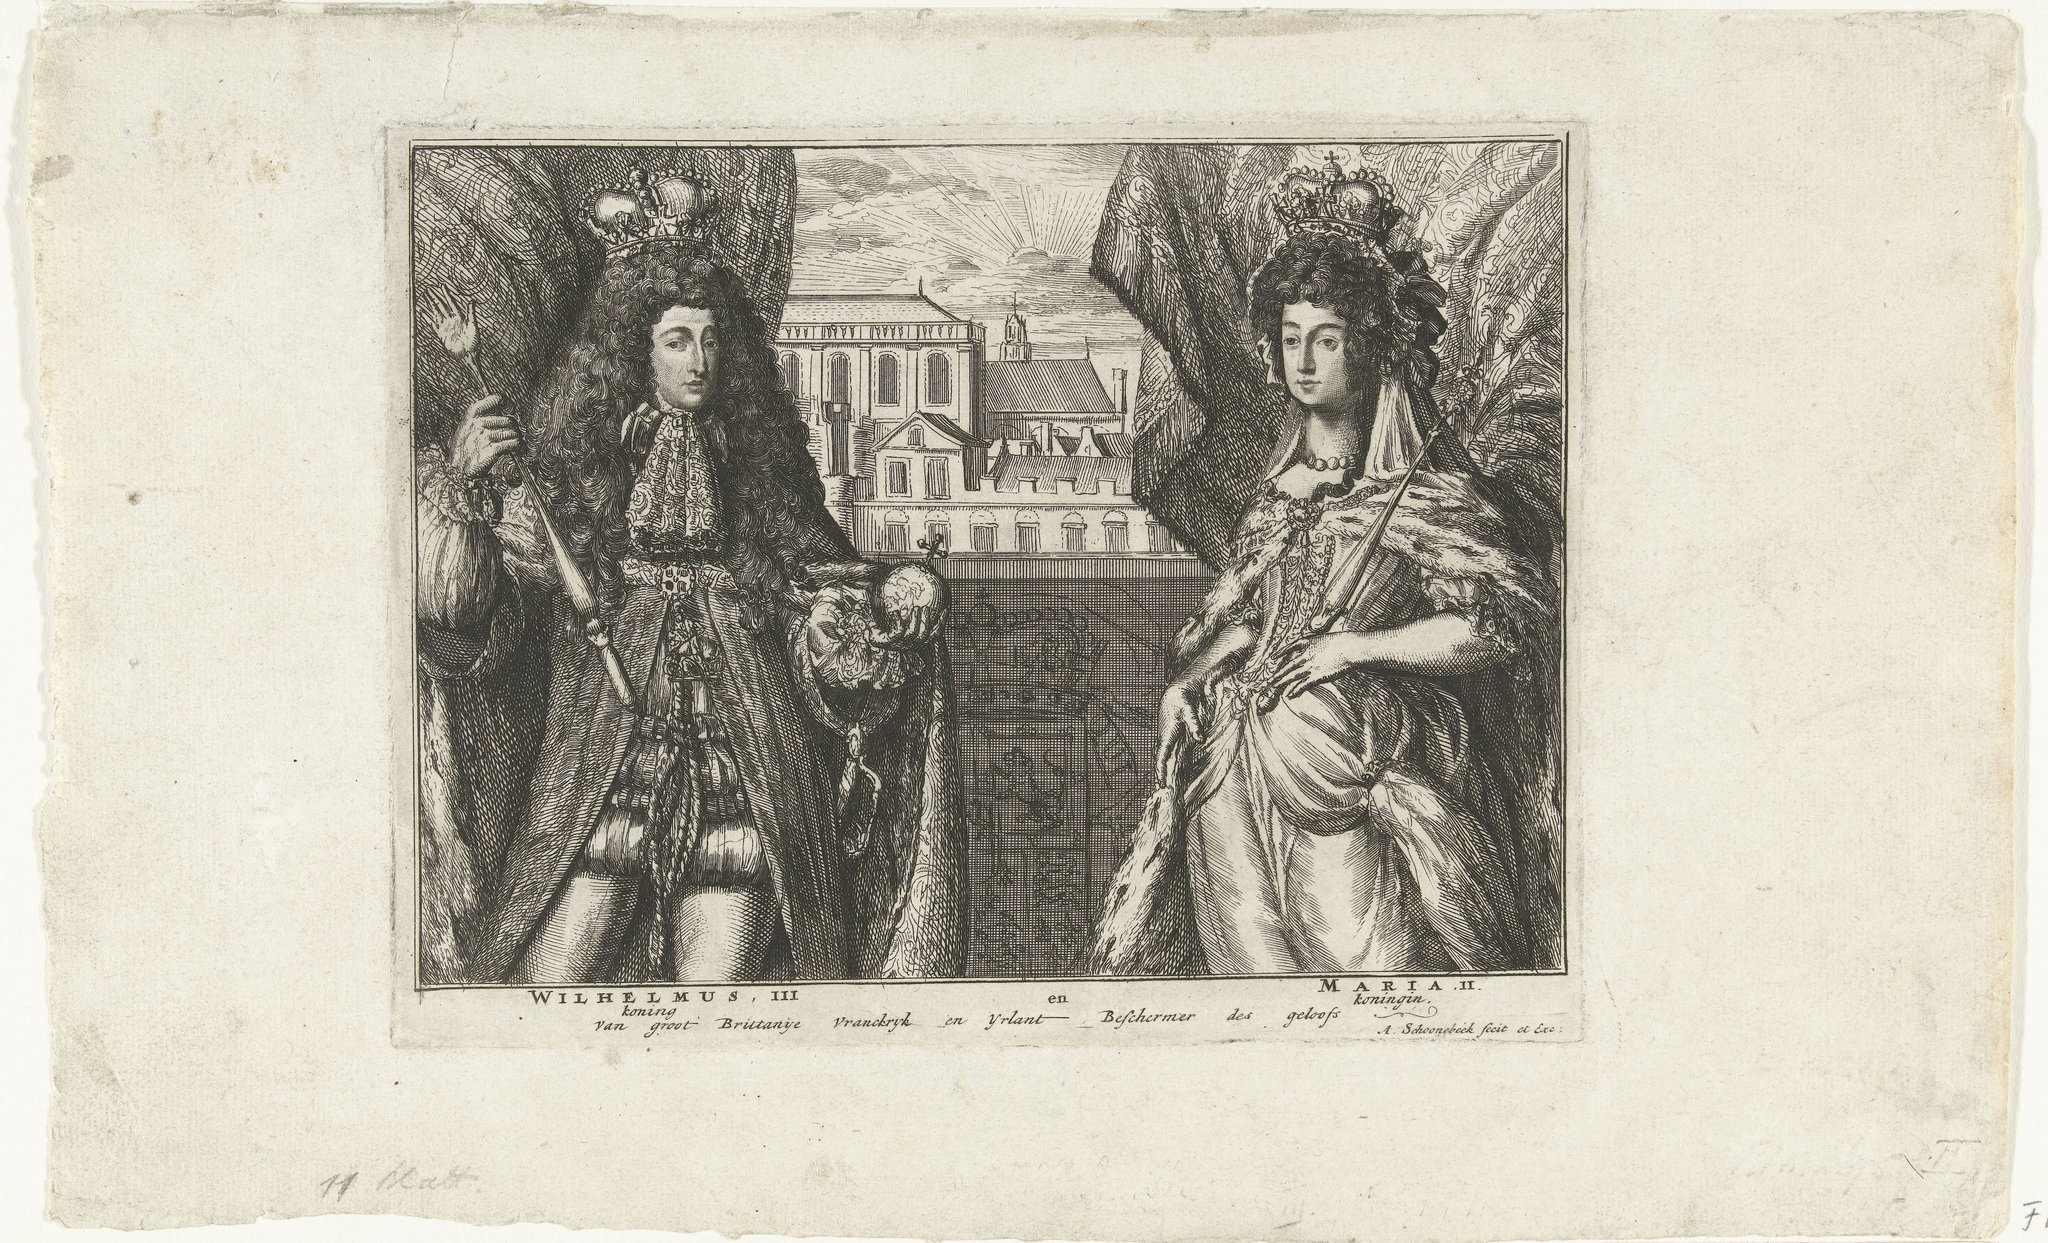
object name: print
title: Wilhelmus III en Maria II koning en koningin Van groot Brittanye Vranckryk en Yerlant, Beschermer des geloofs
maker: adriaen schoonebeek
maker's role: print maker, publisher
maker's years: 1661-1705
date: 1689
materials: paper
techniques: engraving, etching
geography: amsterdam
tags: the hague, william iii (prince of orange and king of england, scotland, and ireland), london, maria ii stuart (koningin van engeland, schotland en ierland)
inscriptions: collector's mark: Lugt 2760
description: Portretten van koning Willem III en koningin Maria II Stuart, staande met kronen, insignia en in vol ornaat, voor een balustrade. Gekroond op 21 april 1689. Onderdeel van de serie 'Engelants schouwtoneel' over de Glorious Revolution 1688-1689 (tweede deel). Met onderschriften in het Nederlands en Frans.